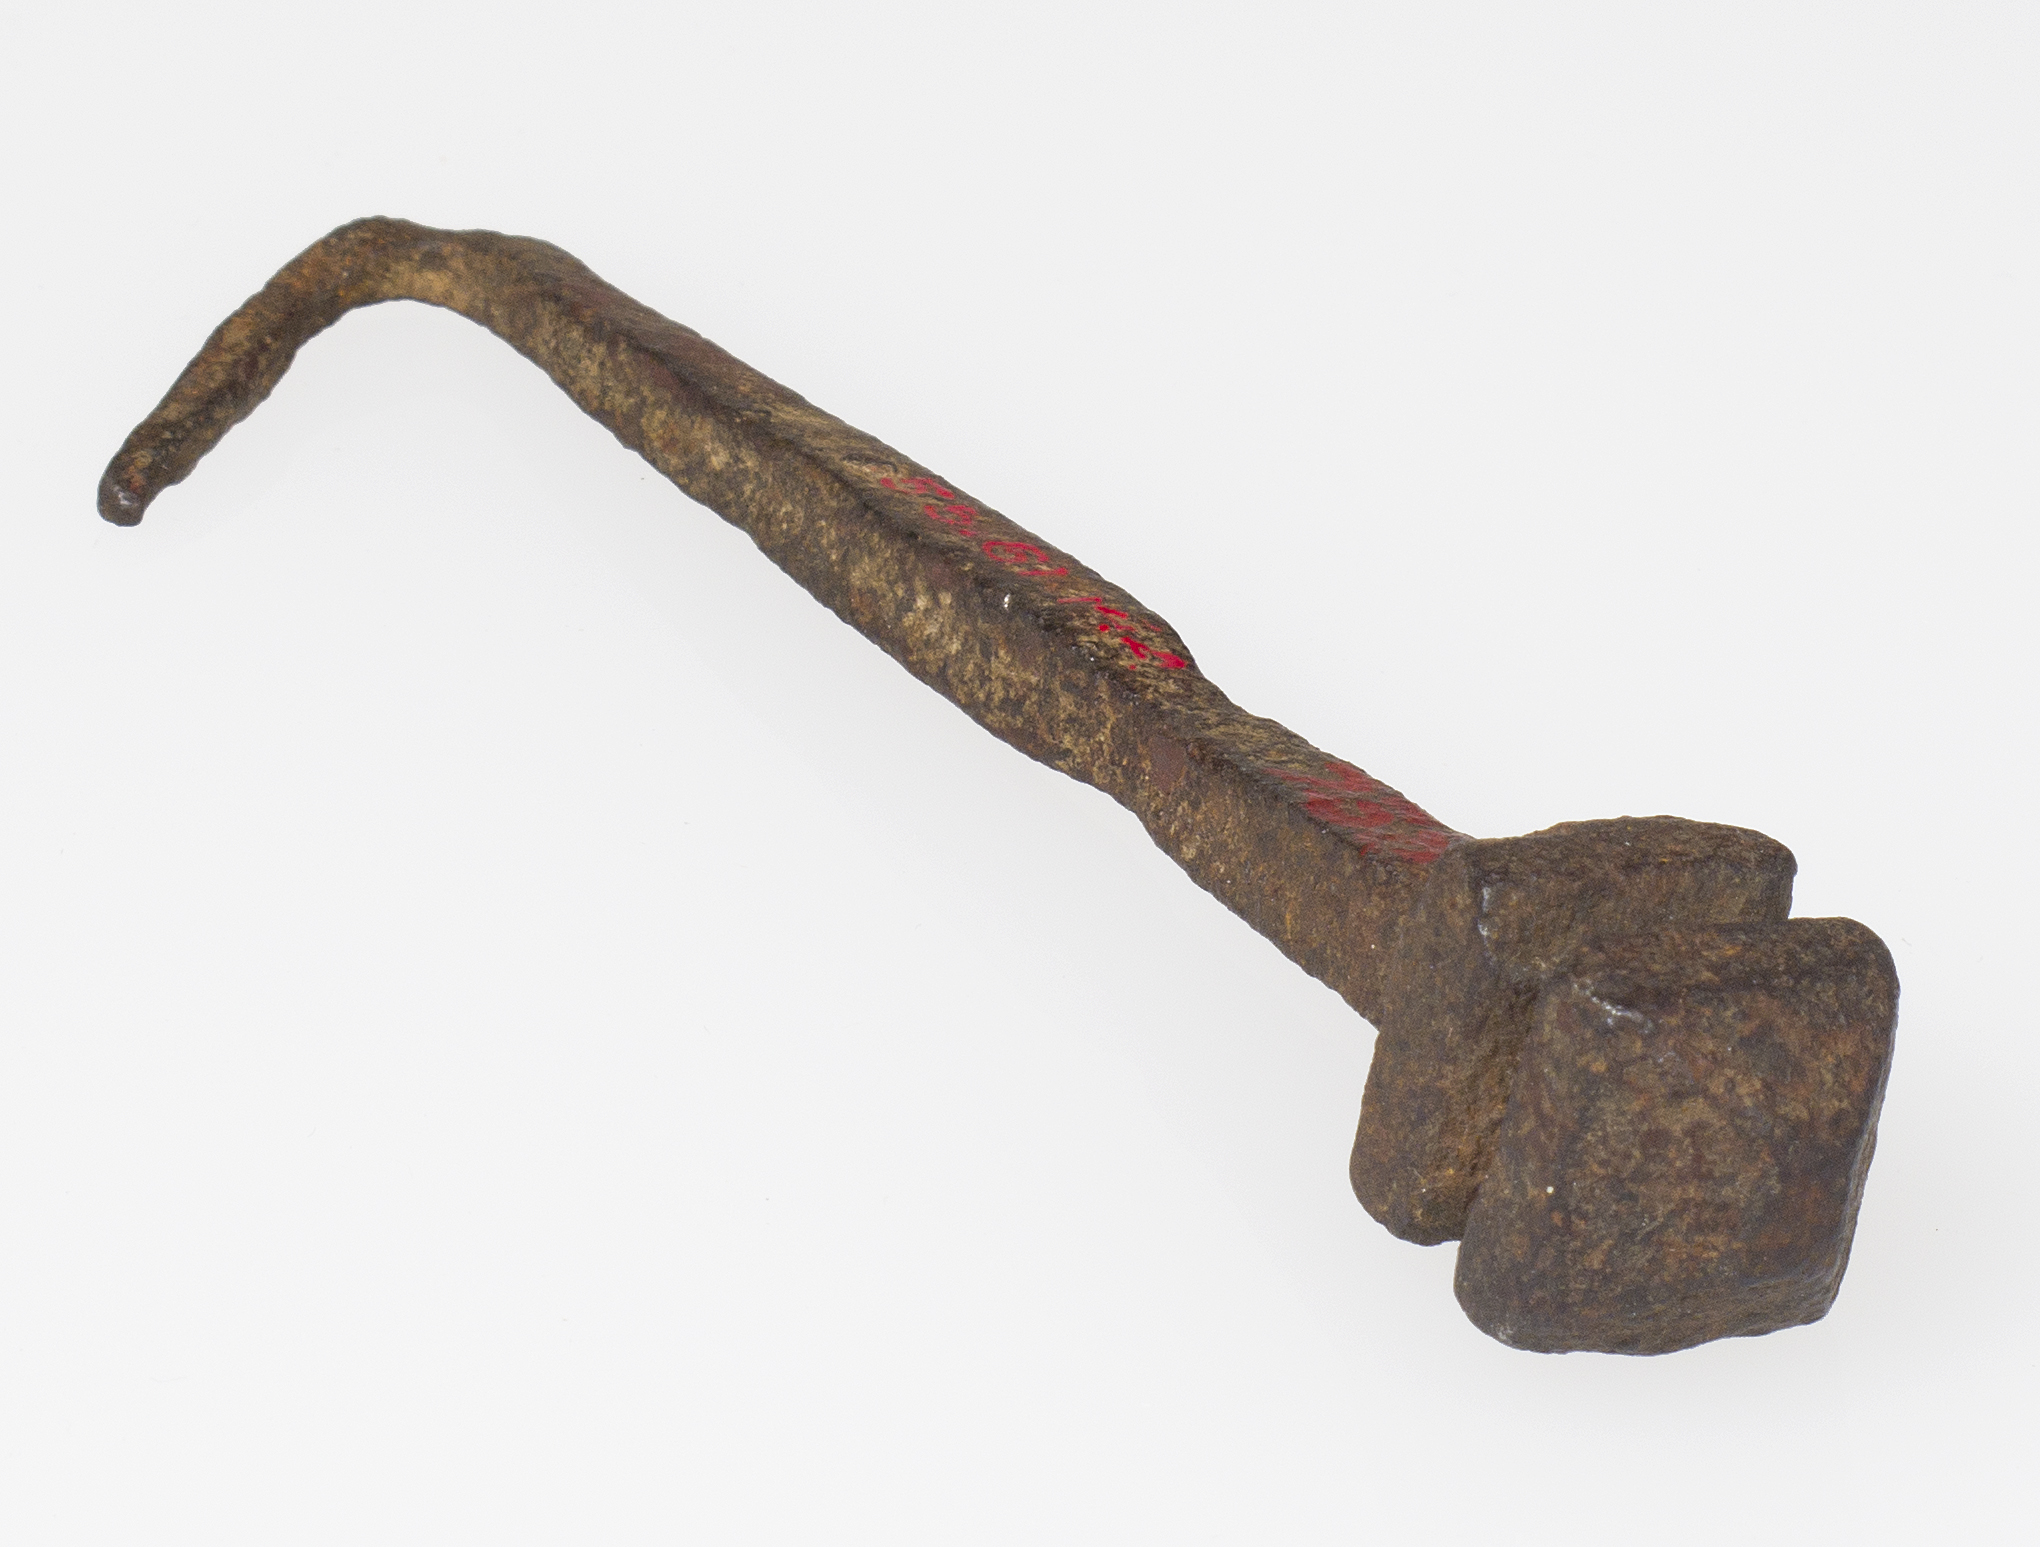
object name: nail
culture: european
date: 1401-1600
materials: iron